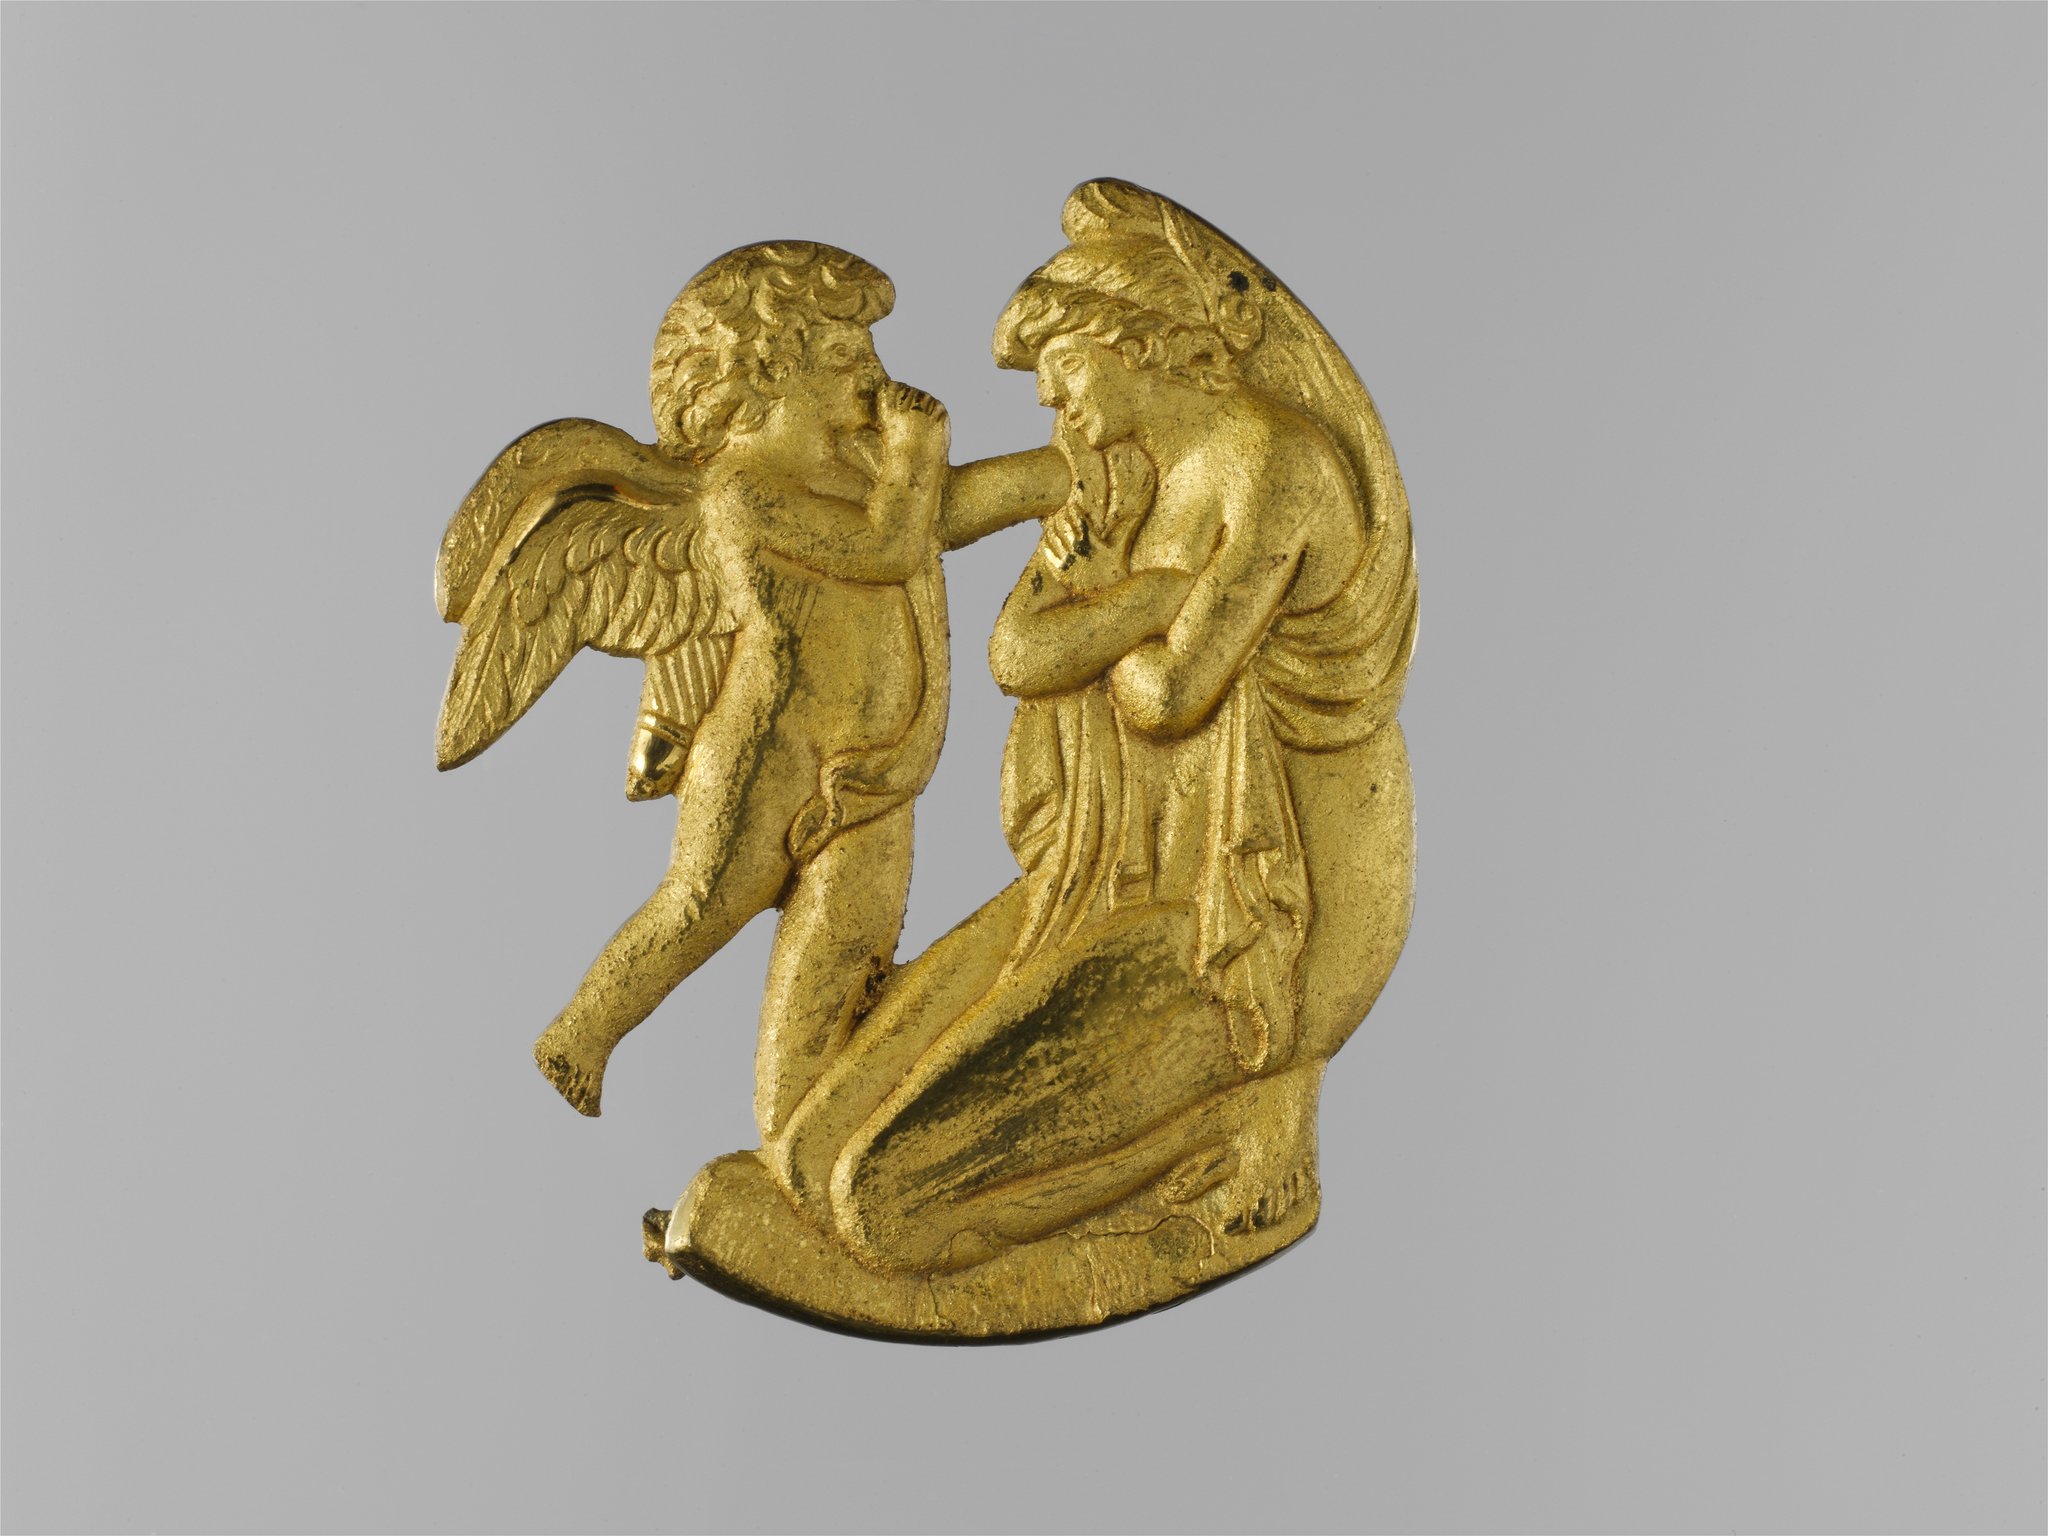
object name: appliqué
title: Cupid and Venus Appliqué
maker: henry kellam hancock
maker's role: retailer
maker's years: 1816-1851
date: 1810-1830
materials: brass, lacquer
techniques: casting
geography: france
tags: cupid,venus